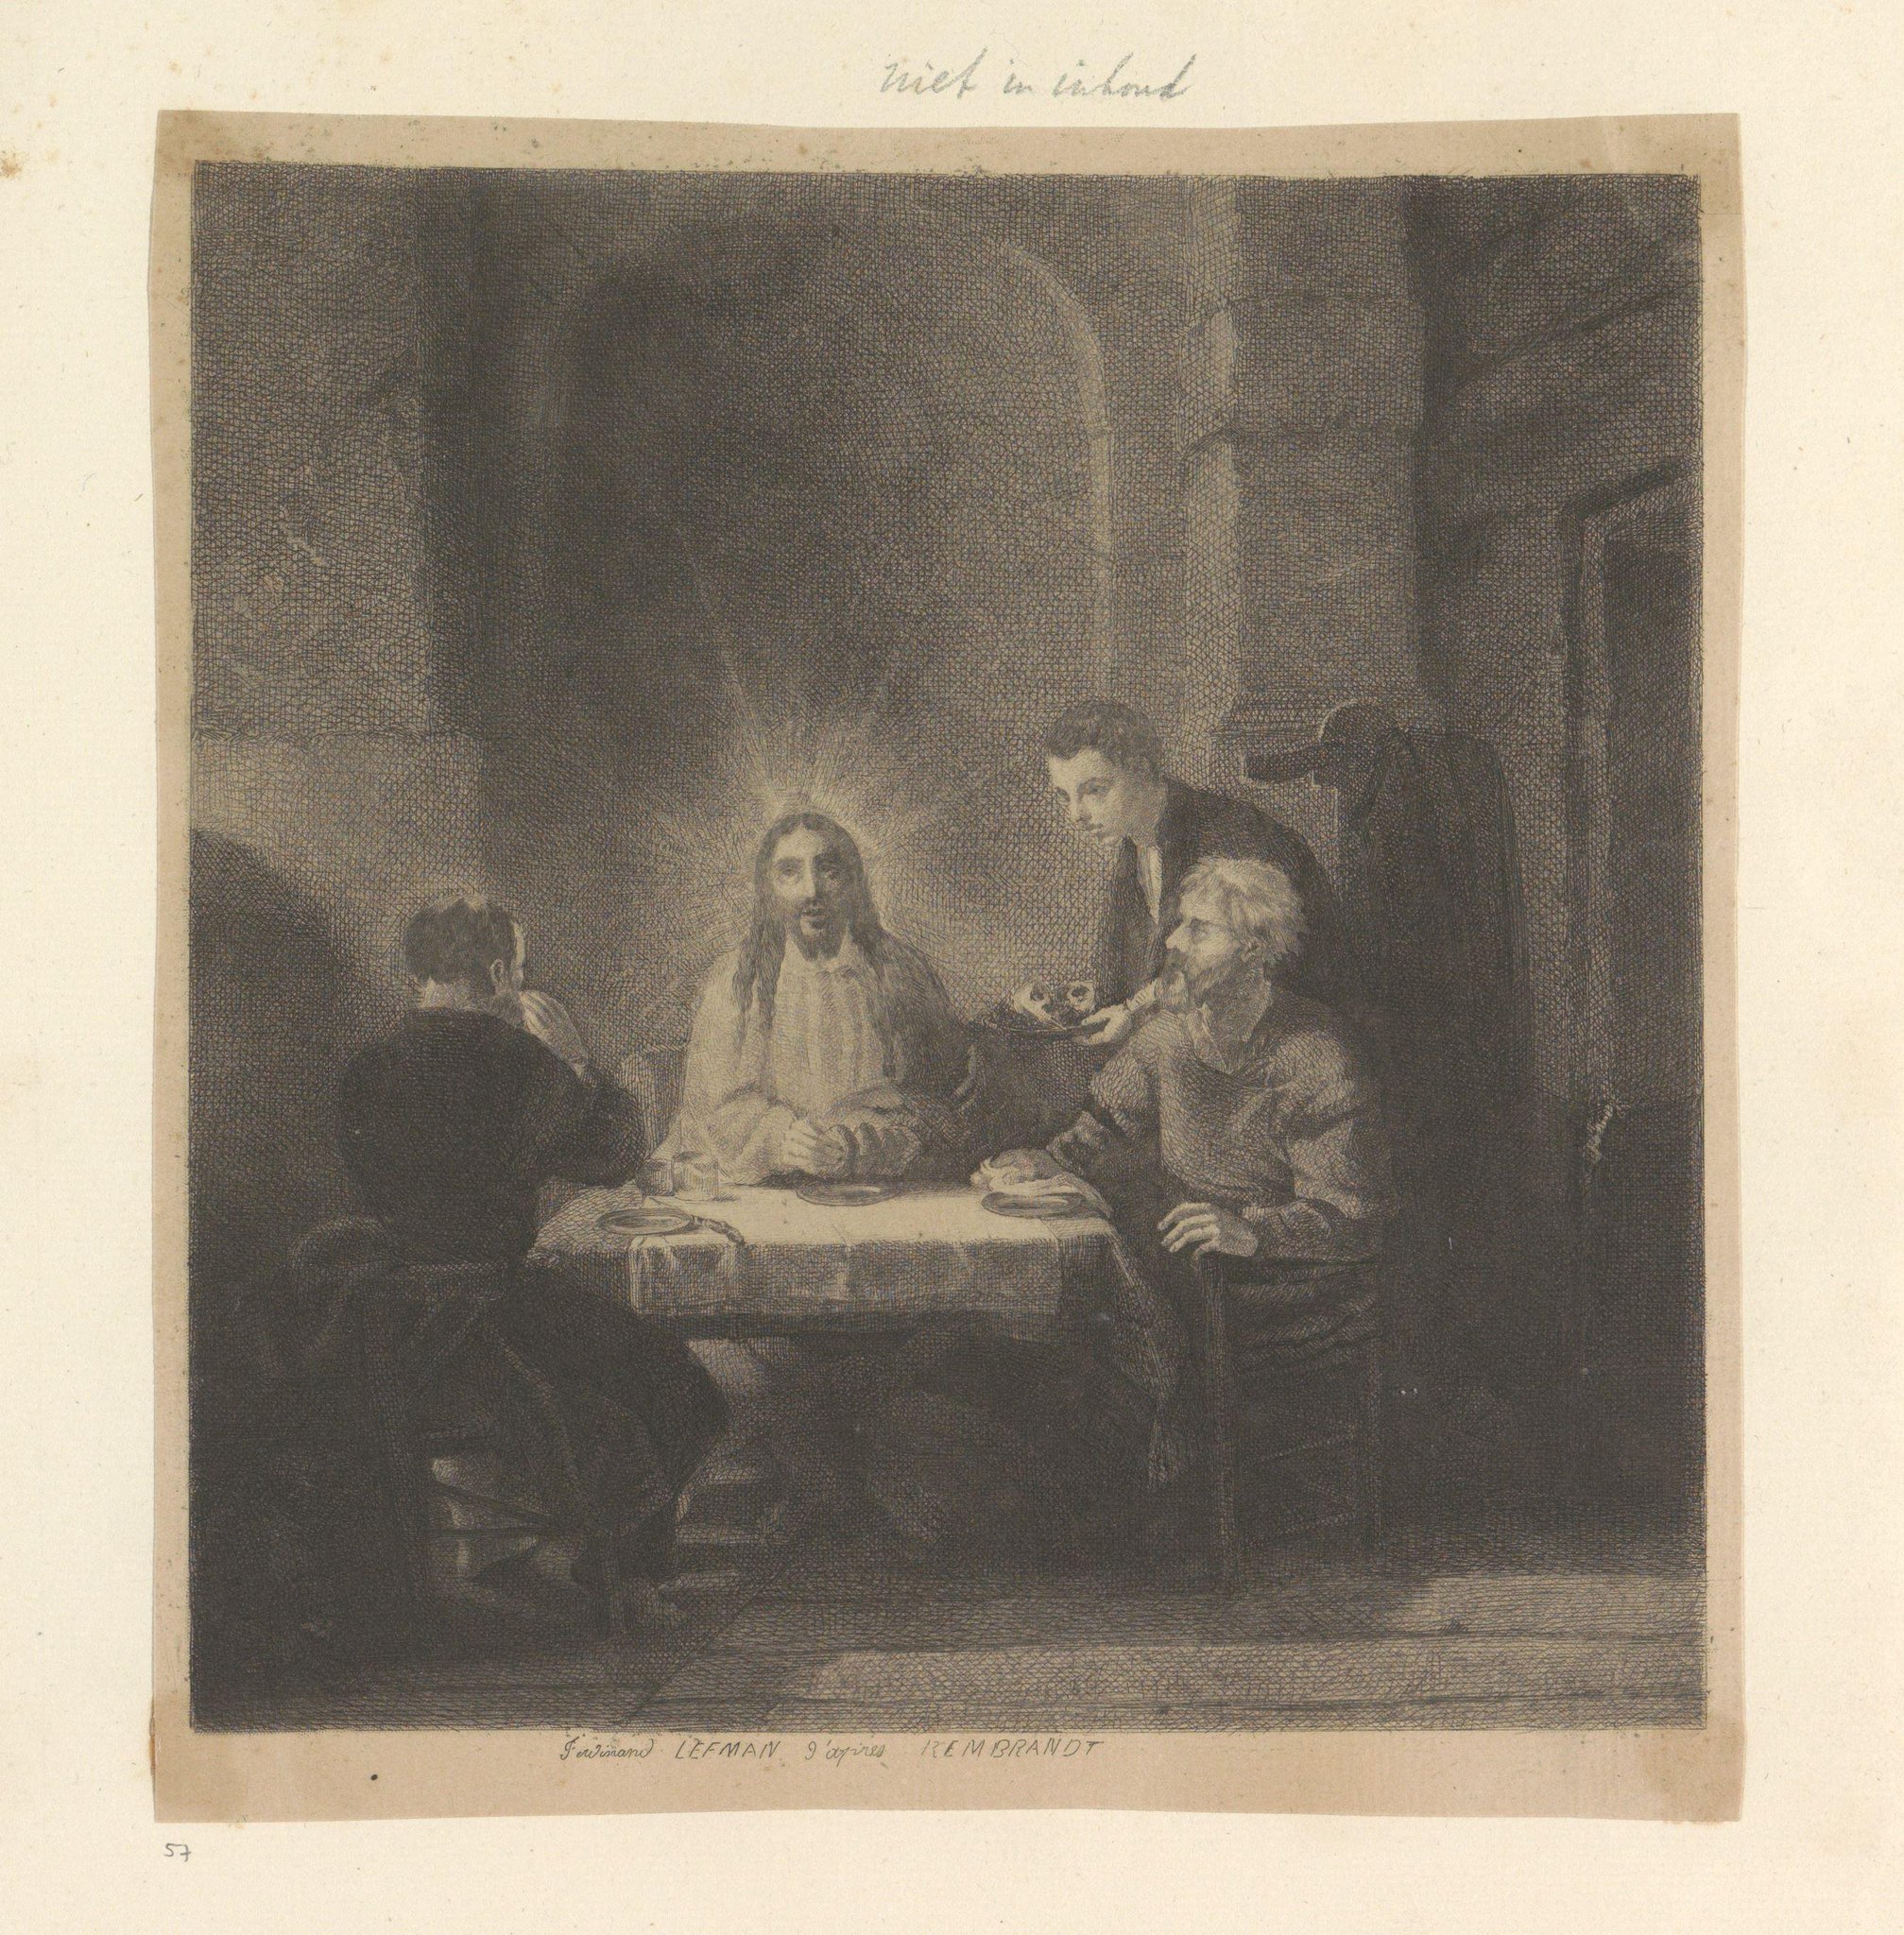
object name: album leaf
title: Maaltijd te Emmaüs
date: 1750-1807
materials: paper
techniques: etching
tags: the supper at emmaus: christ is recognized while blessing or breaking the bread